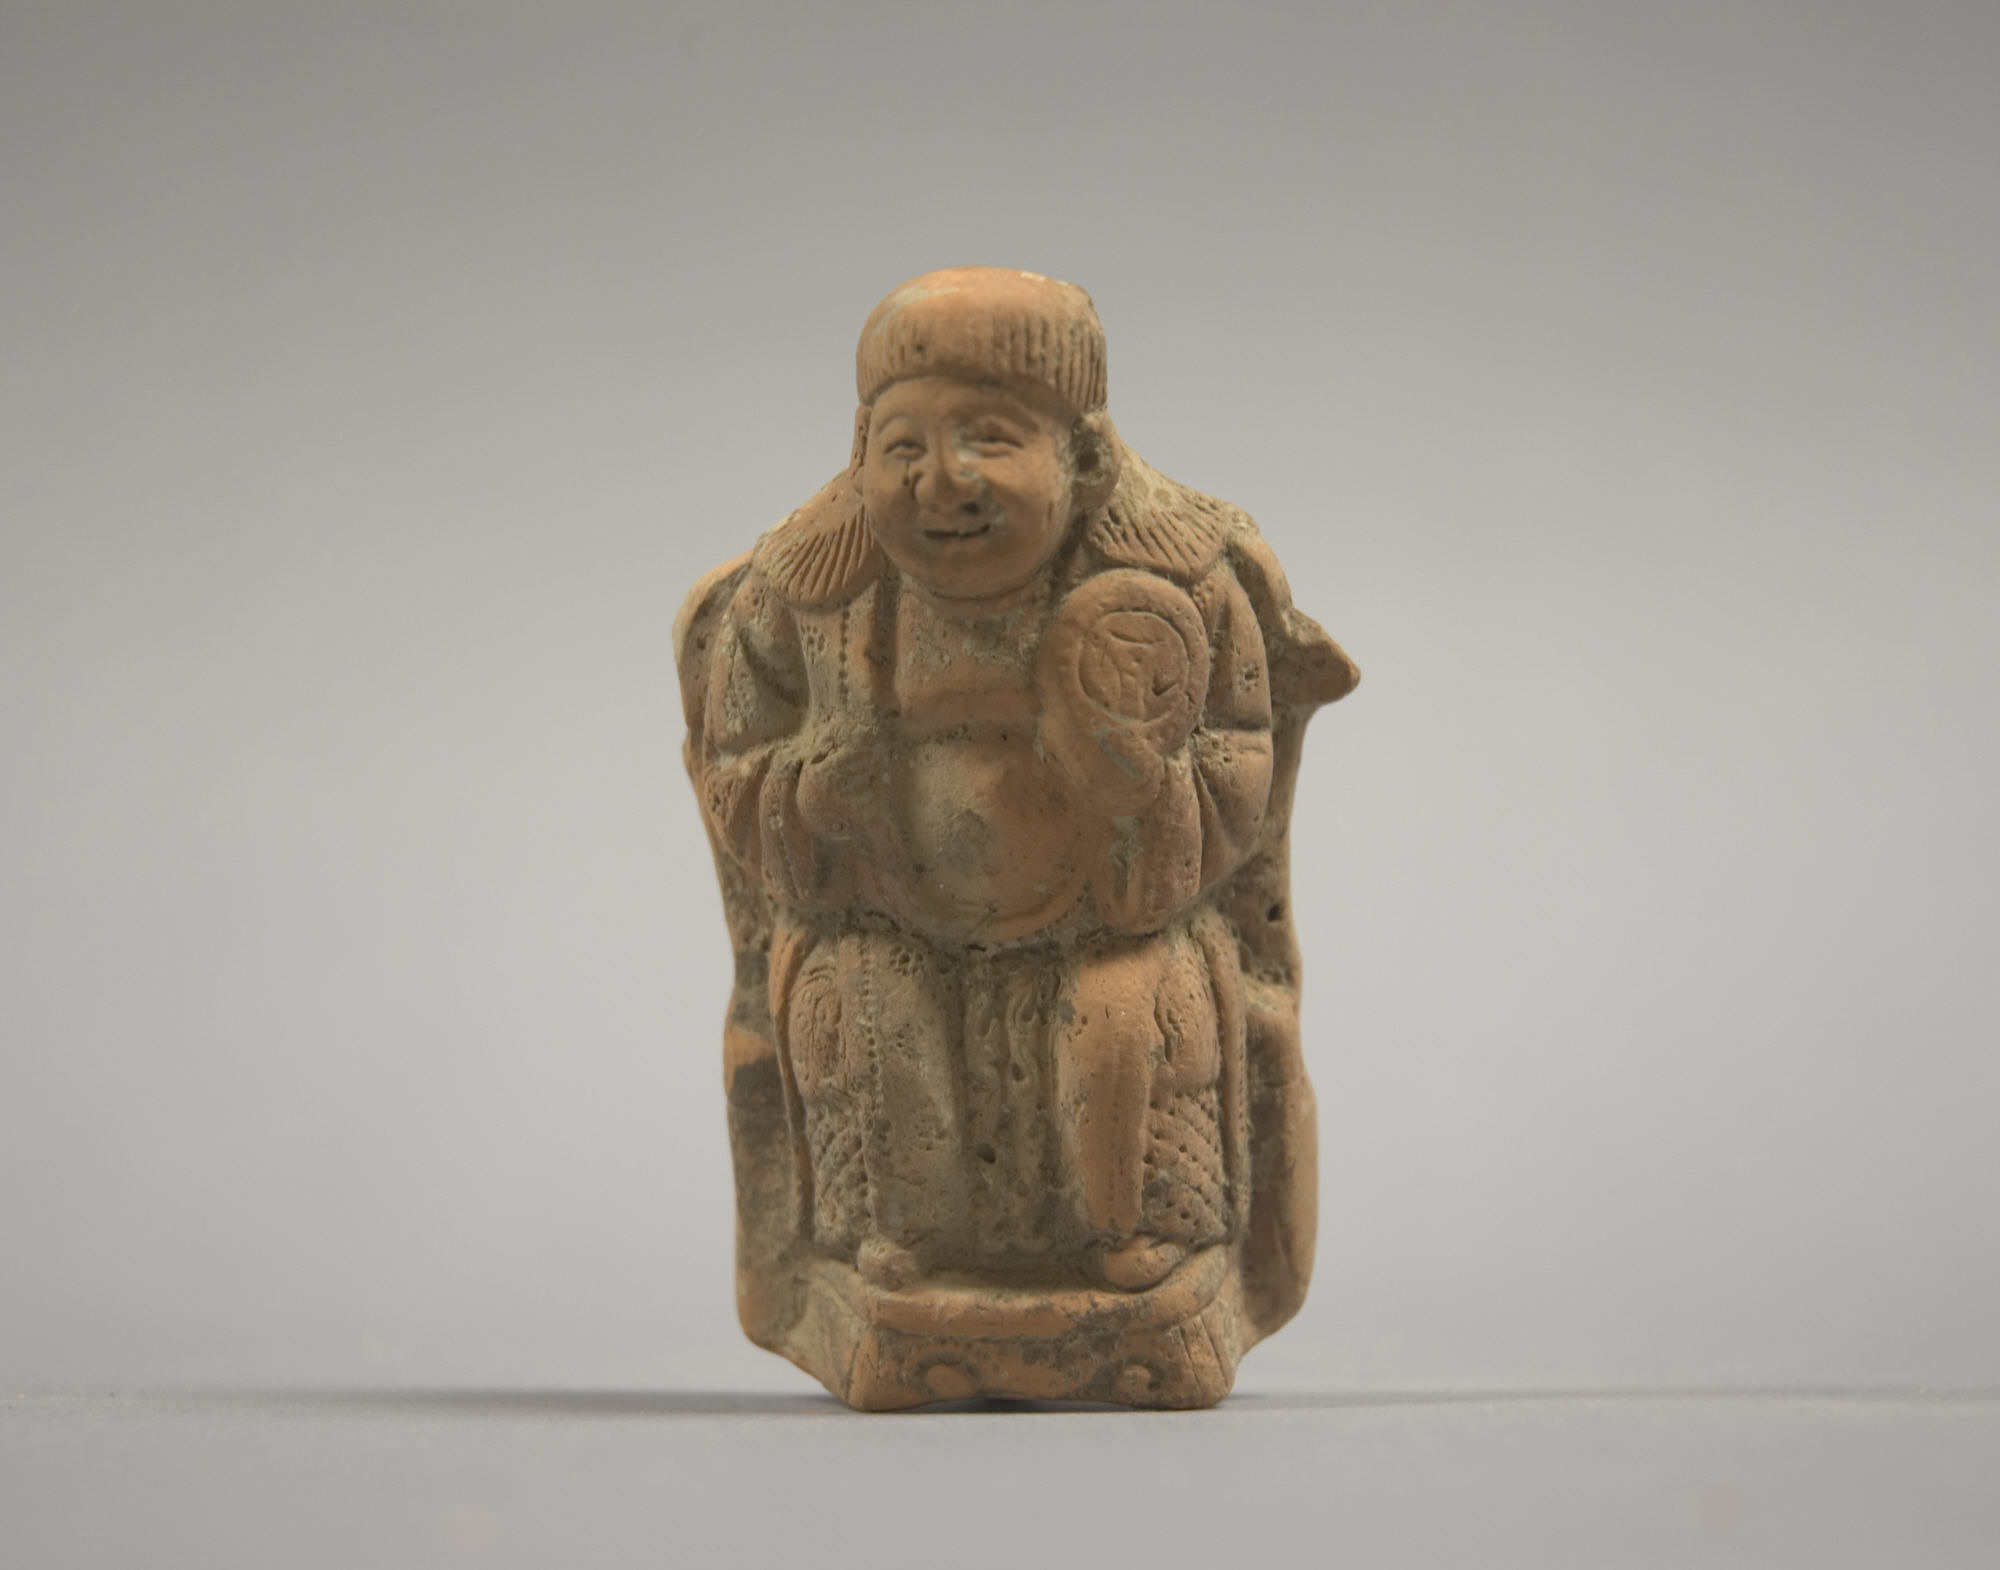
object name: figure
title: Figure of Luohan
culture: chinese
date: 960-1279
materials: pottery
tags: men,buddhism